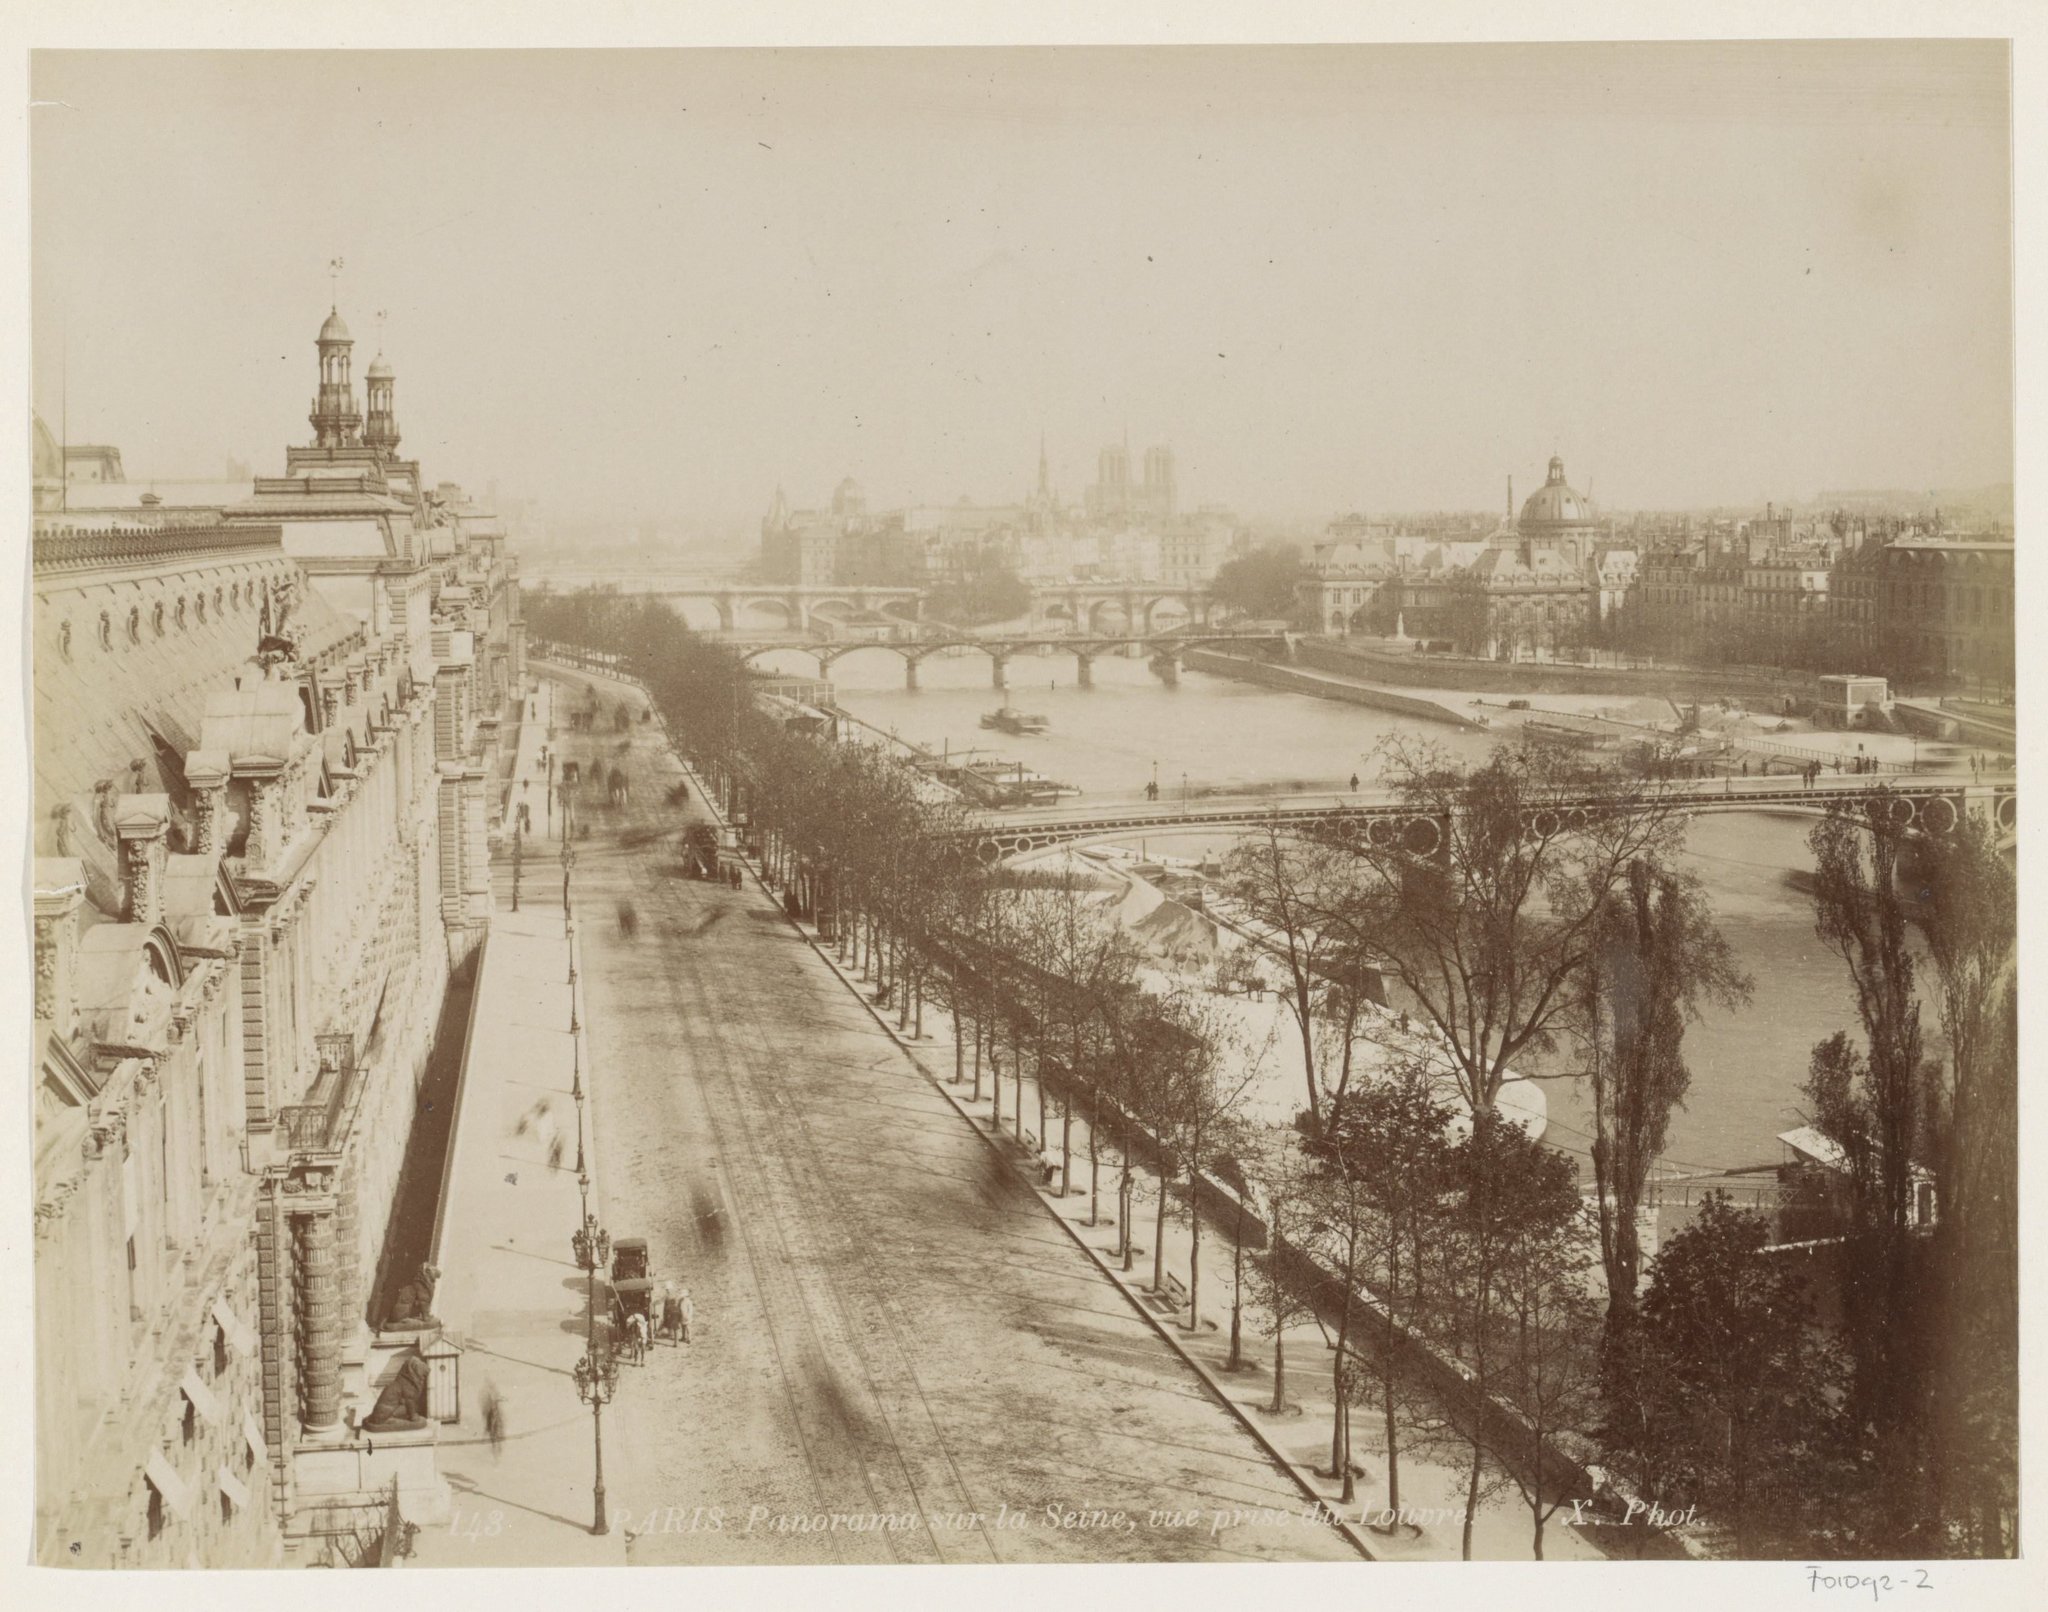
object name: photograph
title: Gezicht op de Seine, gezien vanuit het Louvre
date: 1880-1900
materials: cardboard, paper, photographic support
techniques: albumen print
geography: paris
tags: prospect of city, town panorama, silhouette of city, paris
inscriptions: negative number: ‘143’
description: Onderdeel van Reisalbum met foto's van bezienswaardigheden in België en Frankrijk.